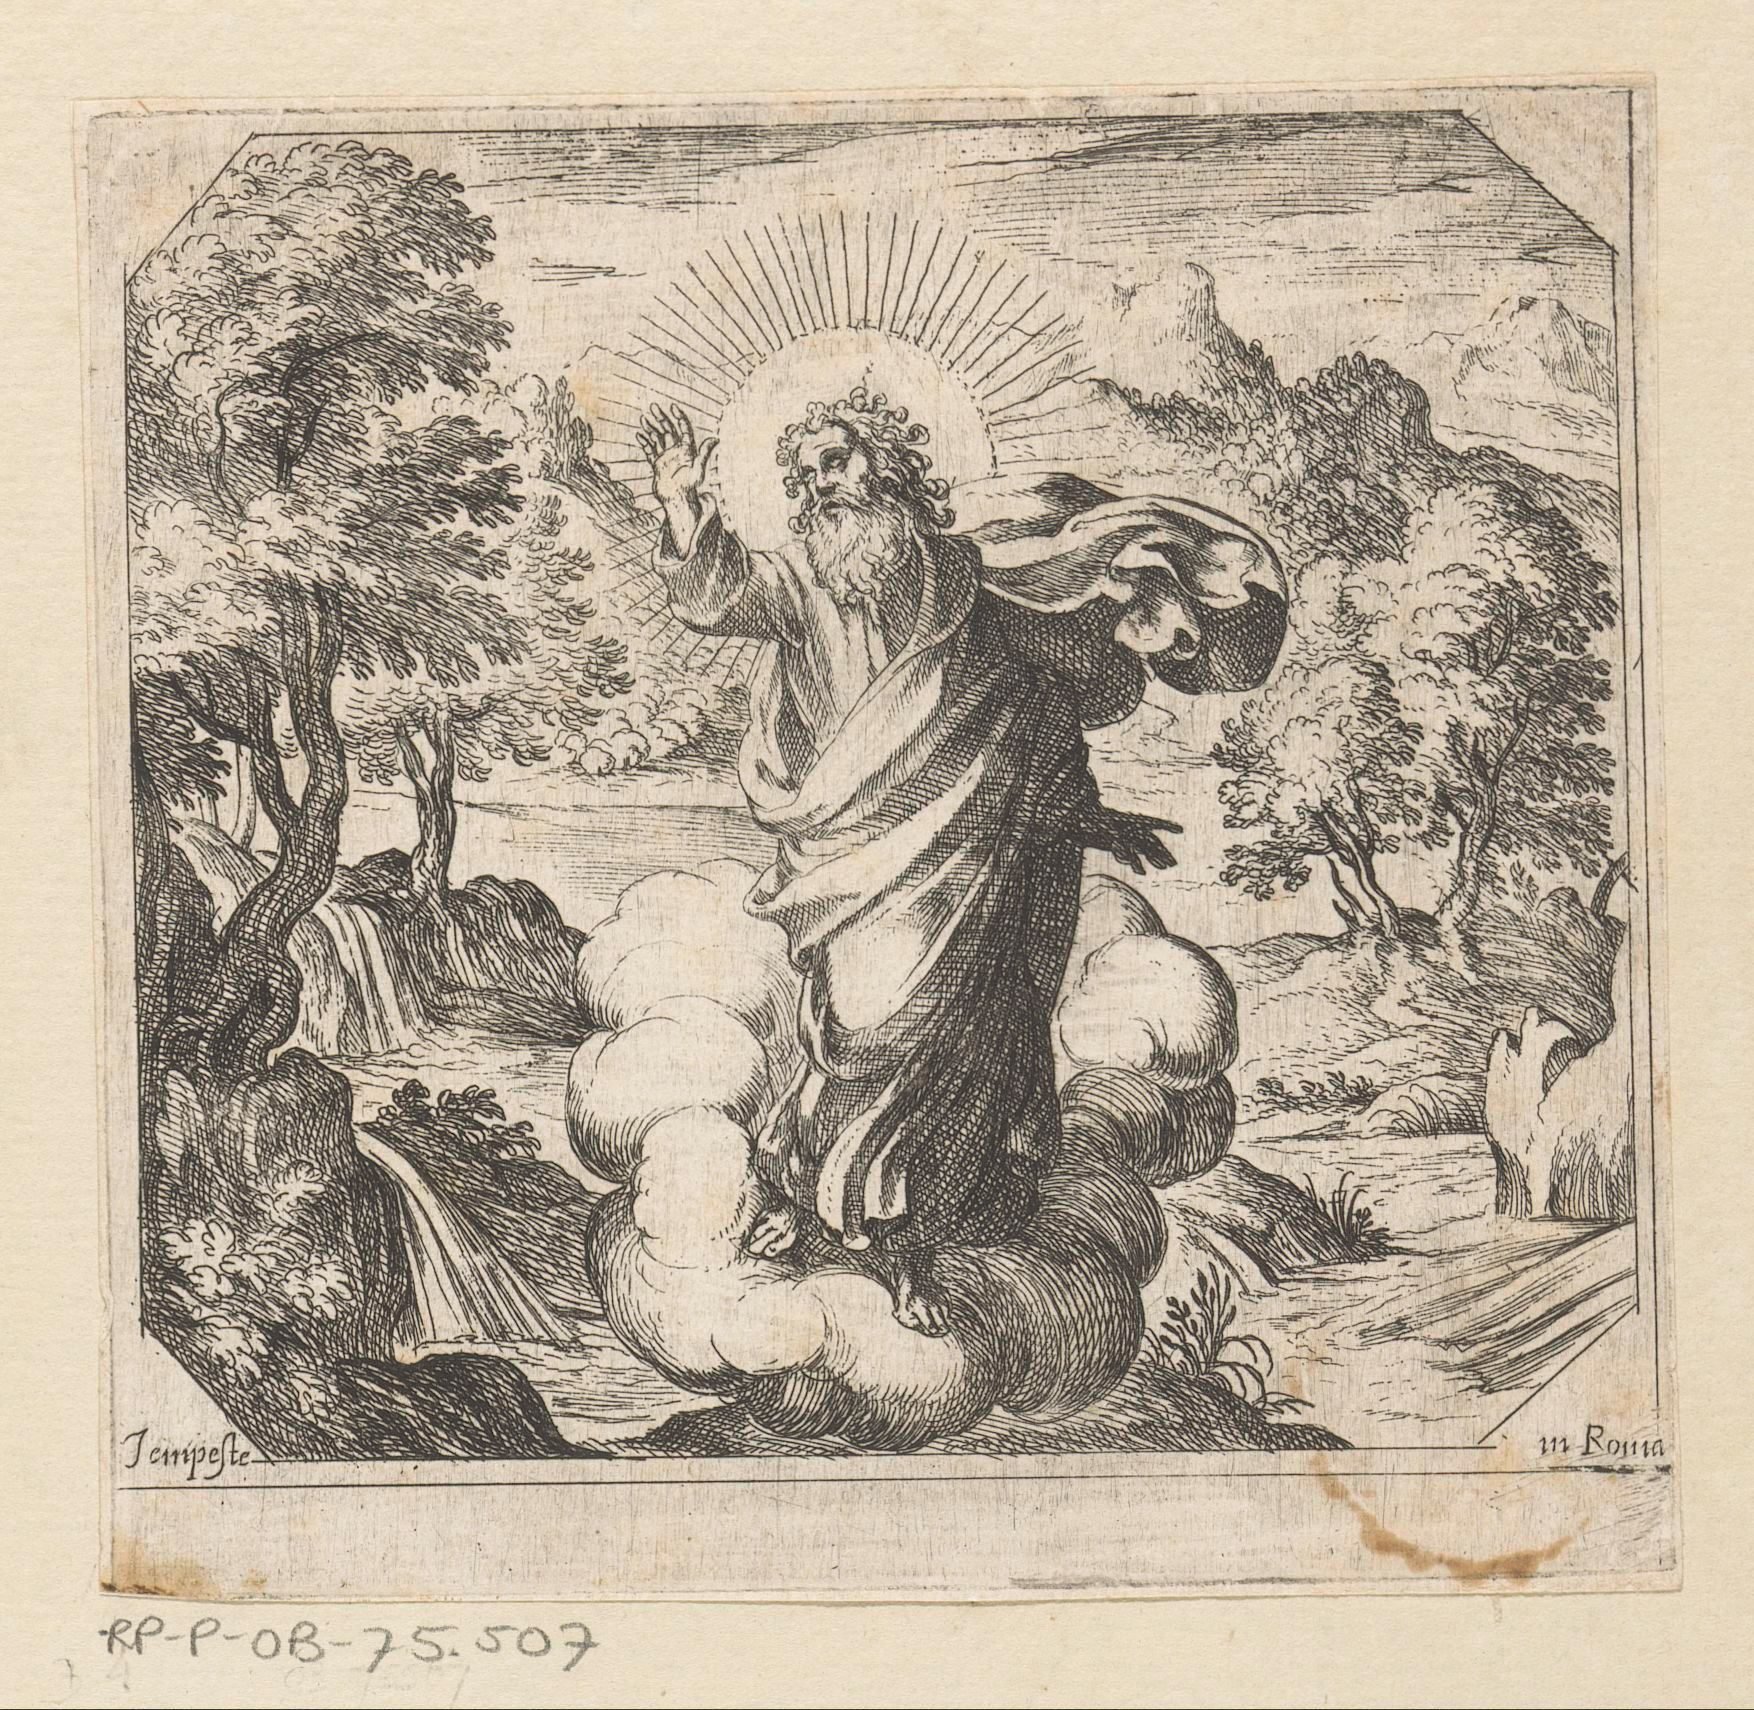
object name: print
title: De schepping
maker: antonio tempesta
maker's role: draughtsman, painter, print maker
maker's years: 1555-1630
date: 1565-1630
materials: paper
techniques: etching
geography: vatican city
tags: gathering of the waters below the firmament; dry land appears and produces all kinds of plants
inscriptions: collector's mark: Lugt 240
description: Deze prent maakt deel uit van een serie van twaalf prenten van de schepping. De prenten zijn deels naar ontwerpen van Rafaël voor de Loggia van Rafaël in het Vaticaan, en deels naar prenten door Nicolaes de Bruyn naar ontwerpen van Maerten de Vos (zie: Holl. Dutch. vol. 45 nr. 1-10).